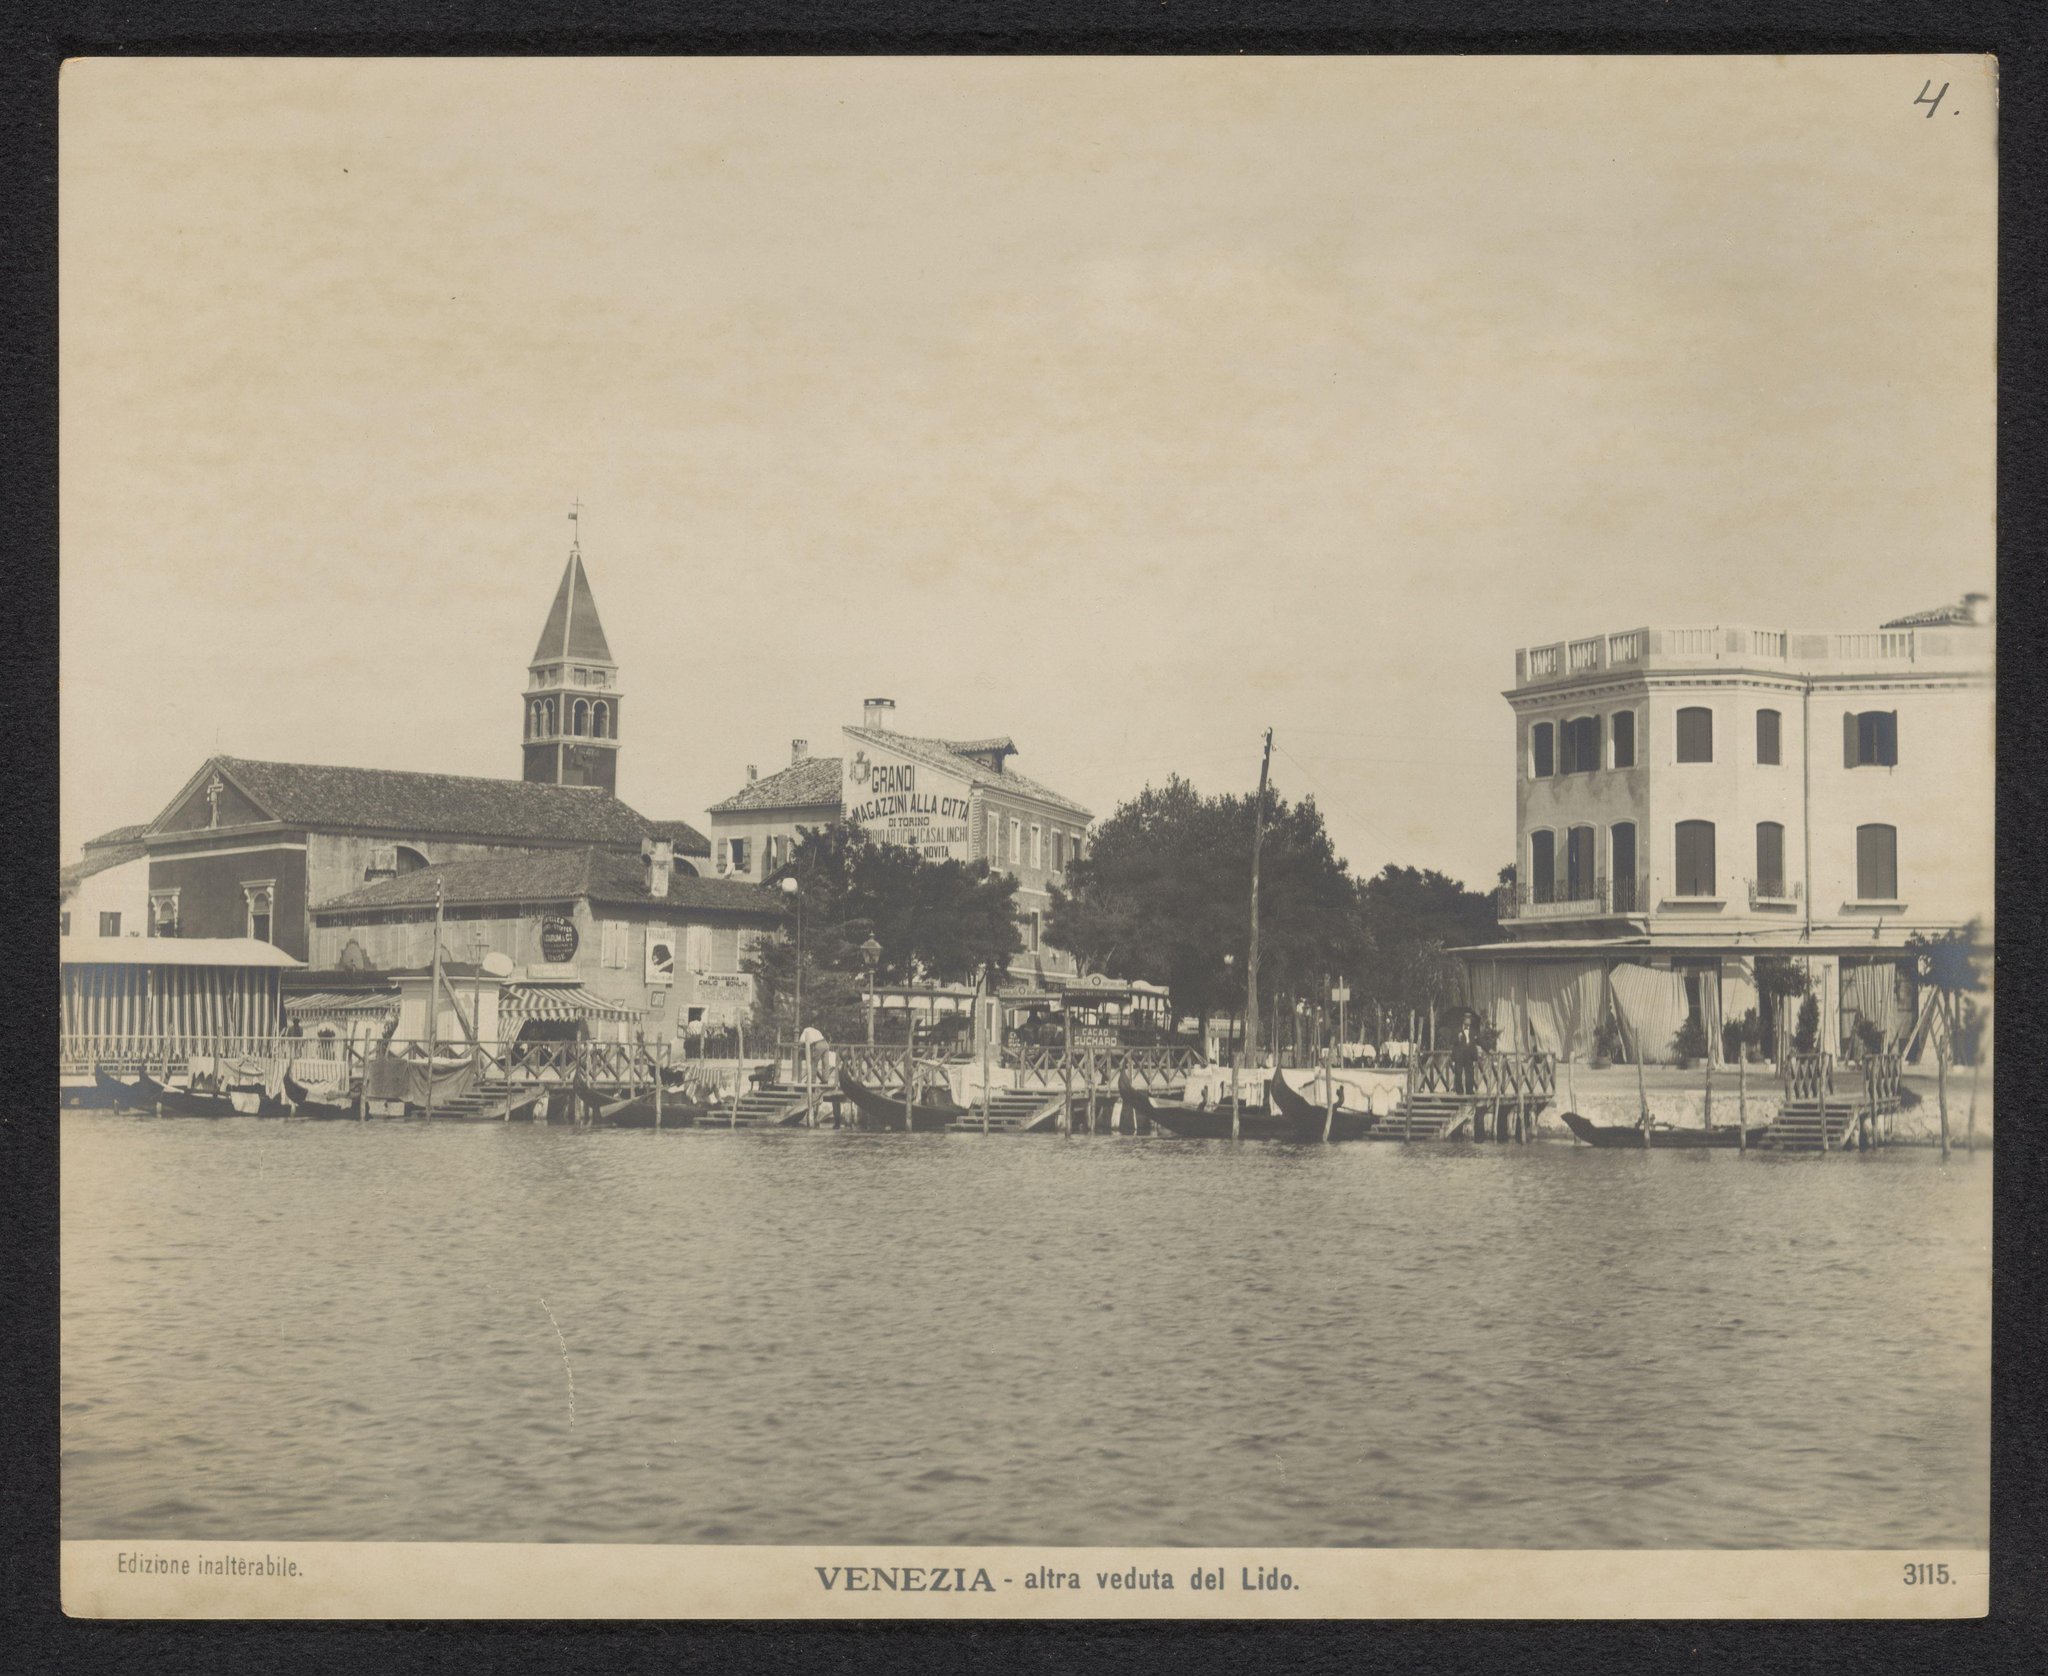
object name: photograph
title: Venezia - altra veduta del Lido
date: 1900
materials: cardboard, photographic support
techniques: gelatin silver print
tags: façade (of house or building), quay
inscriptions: number: ‘3115.’, number: ‘4.’